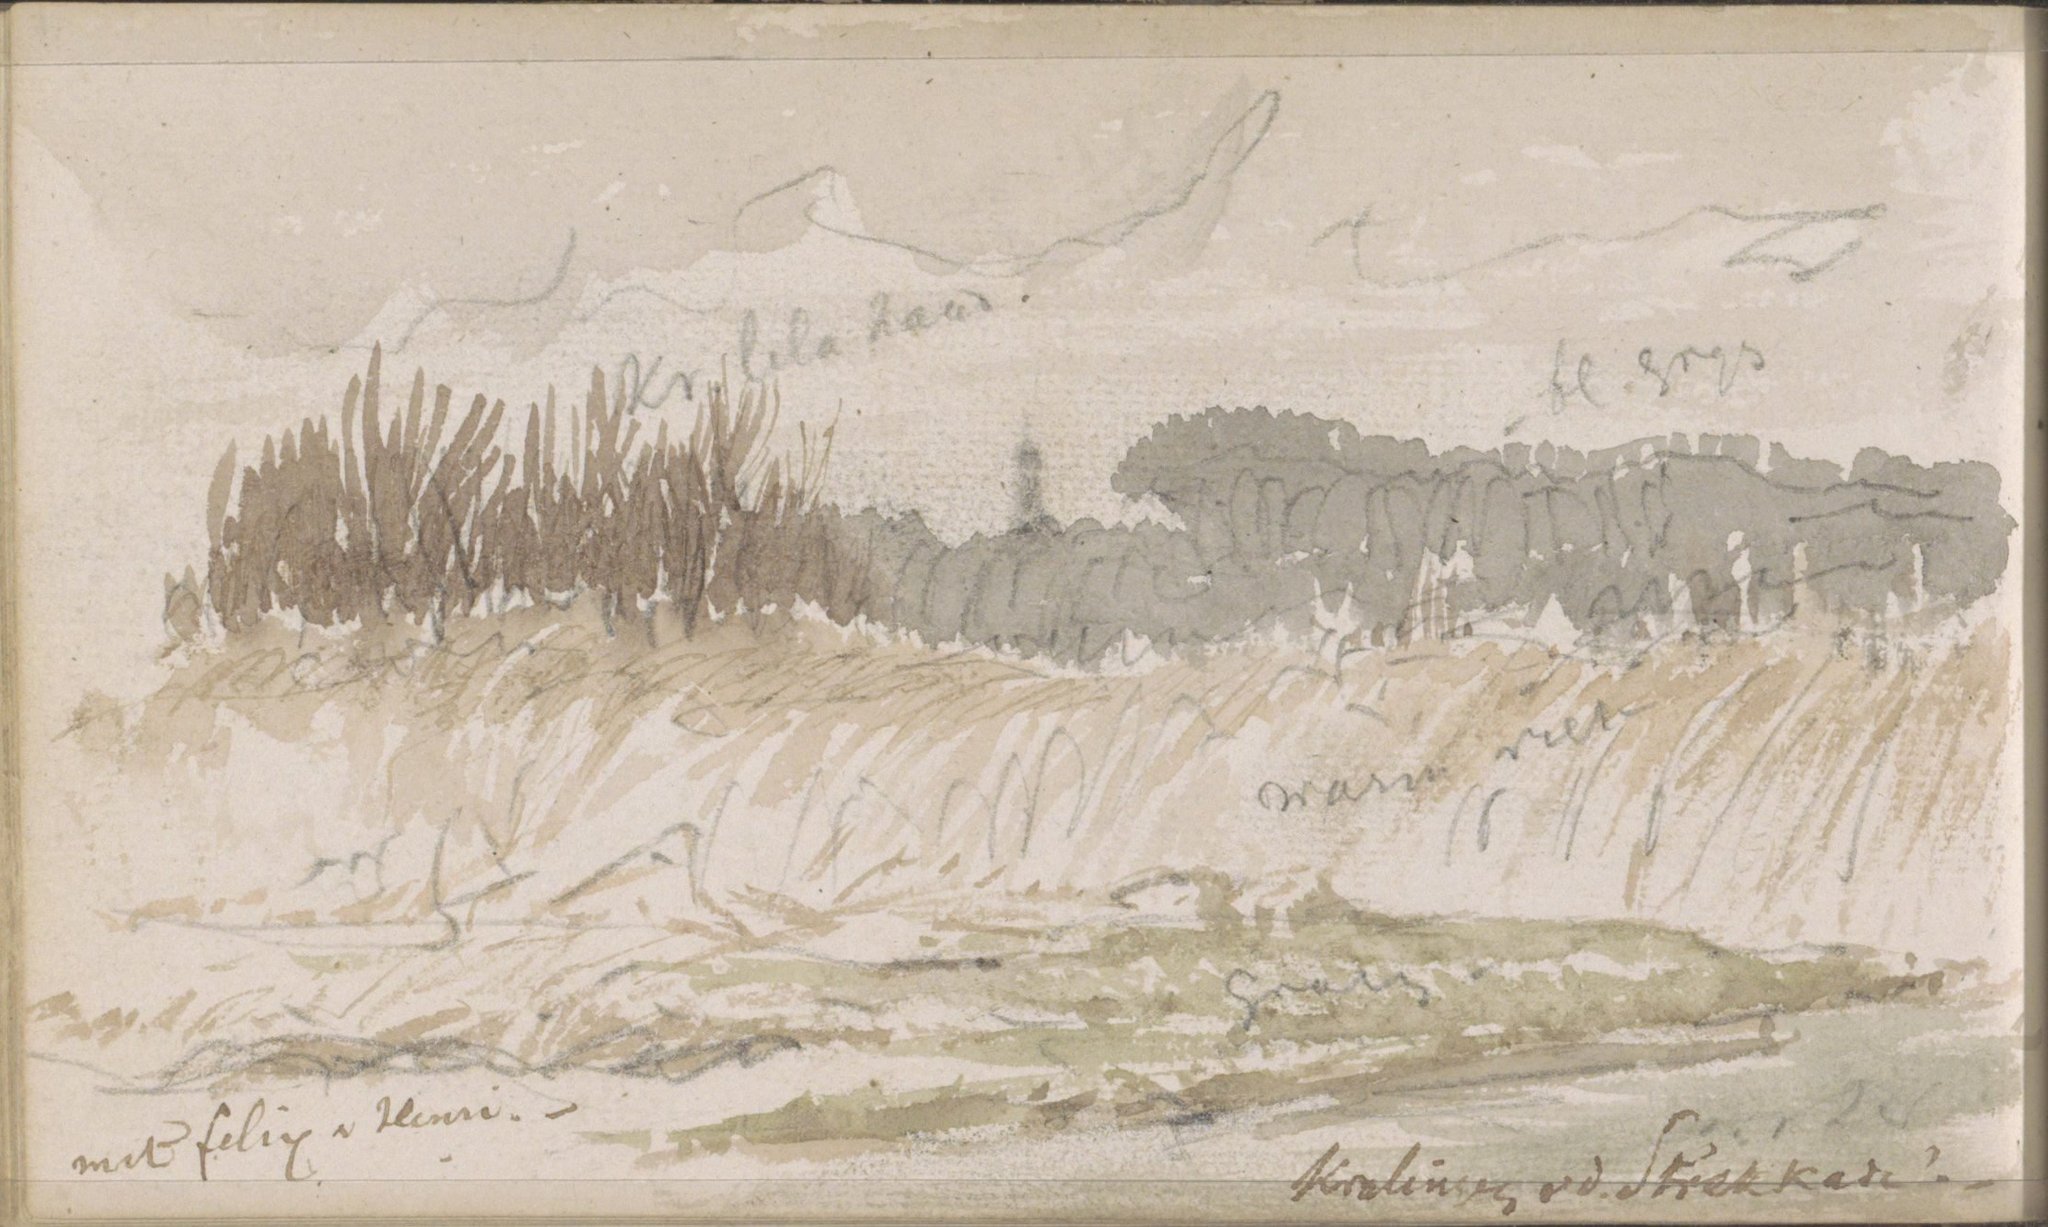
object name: sketchbook leaf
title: Landschap in Kralingen bij de Strekkade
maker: johannes tavenraat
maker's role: draughtsman, painter, print maker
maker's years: 1809-1881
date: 1864-1880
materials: paper, pencil, watercolor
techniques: brush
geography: kralingen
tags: landscapes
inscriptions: date and inscription: ‘met felix & Henri - Kralingen ad Strekkade.’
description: Blad 72 verso uit een schetsboek met 98 bladen.